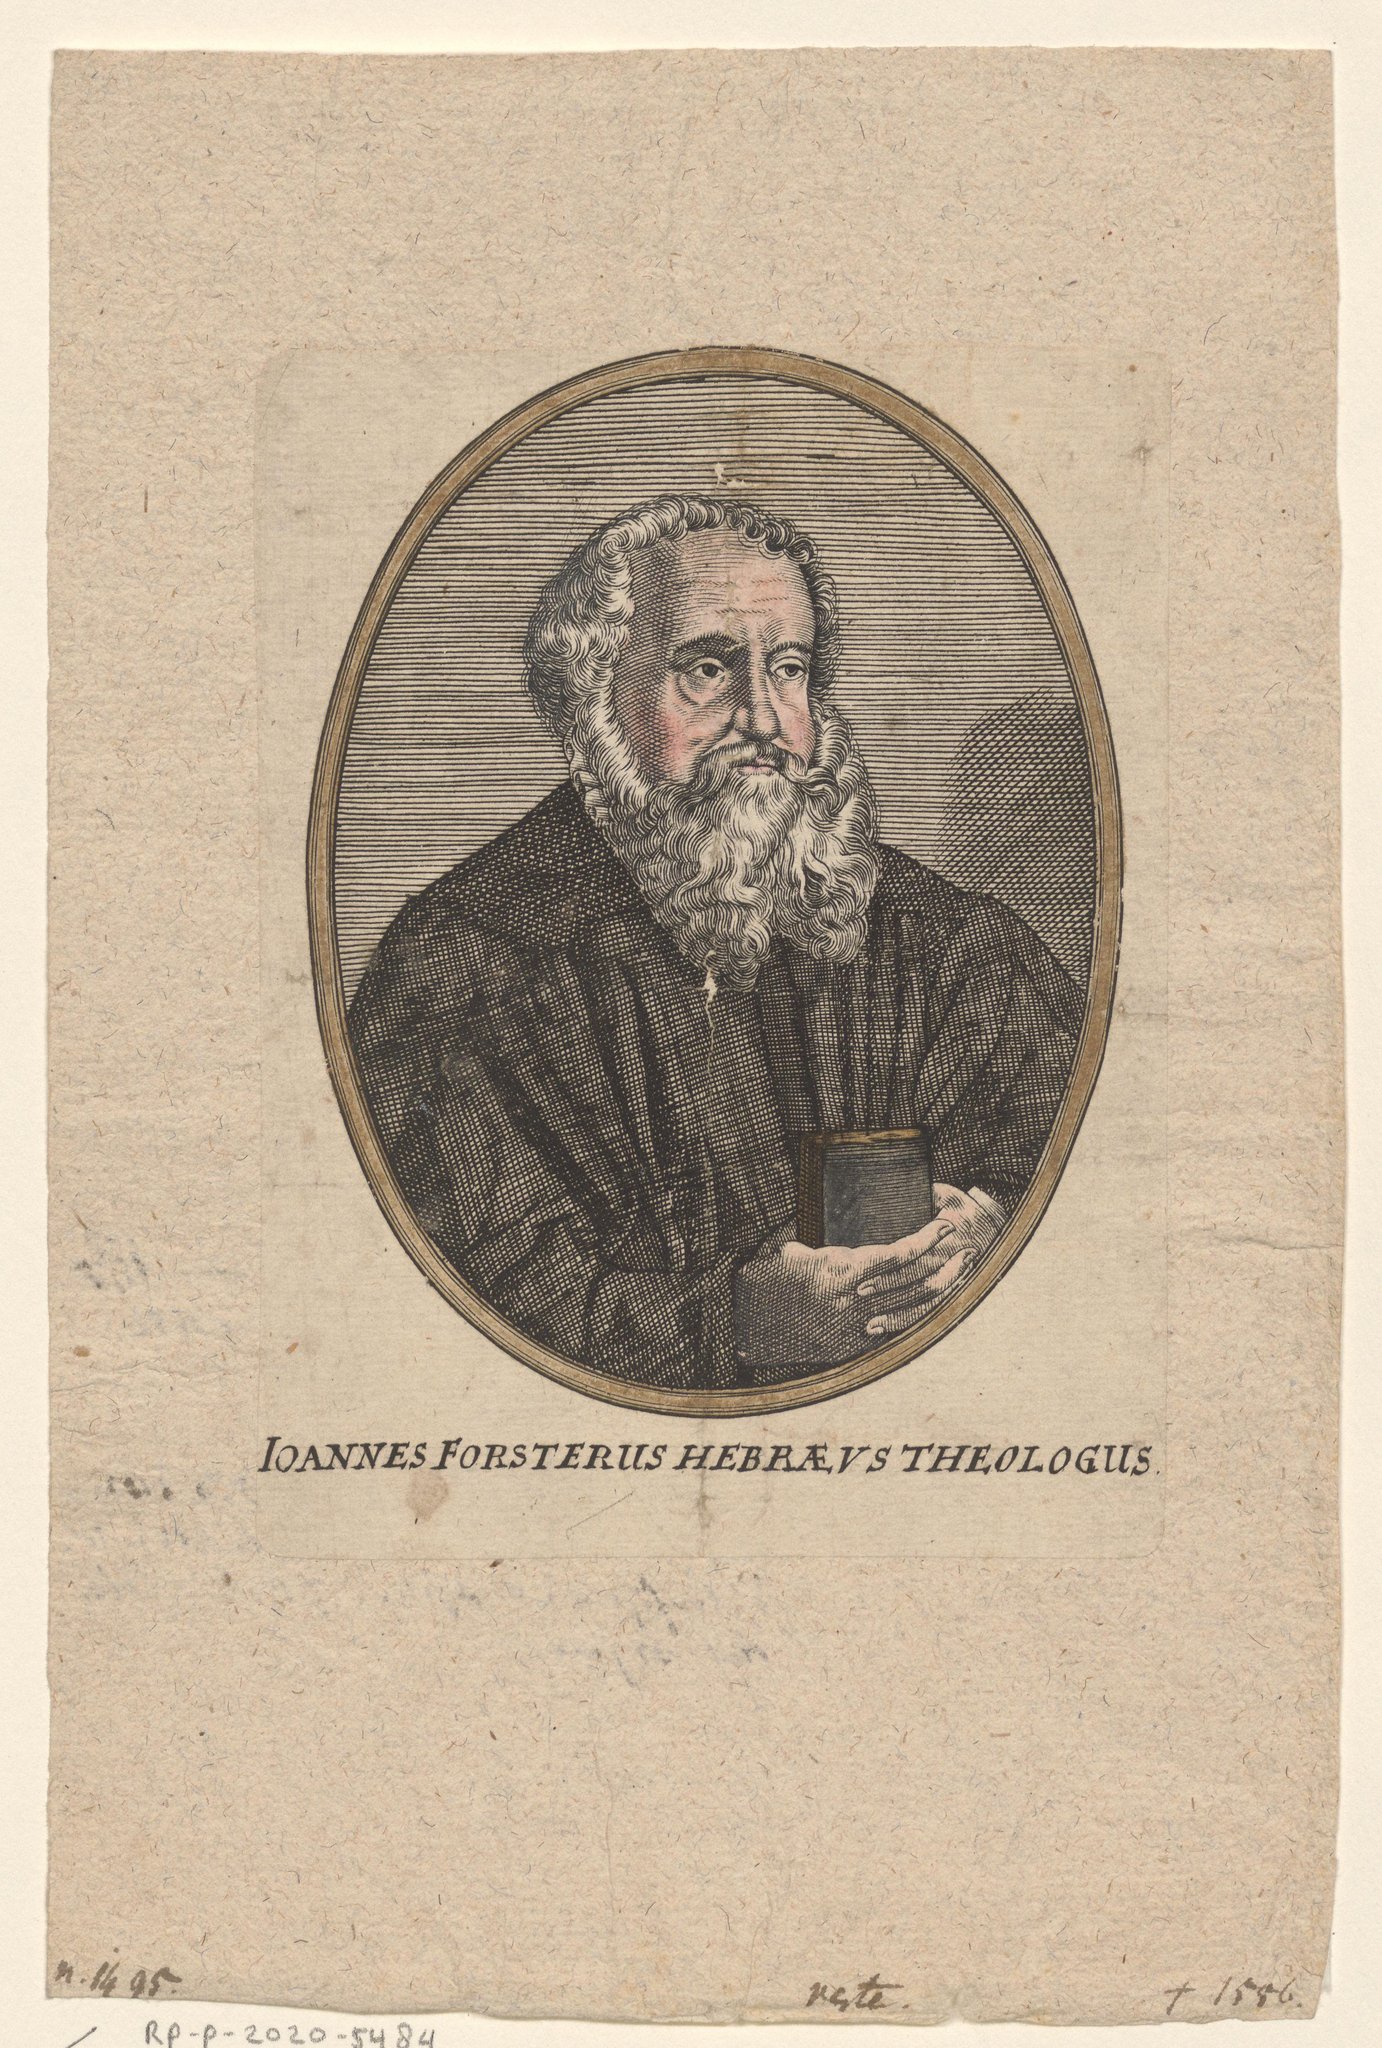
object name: print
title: Portret van Johann Forster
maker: Anonymous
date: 1600-1699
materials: paper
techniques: engraving, hand coloring, snipping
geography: germany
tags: augsburg, theologian, historical persons, book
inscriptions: inscription: ‘J.F. senior, Luther. Theolo., Philol., nat. Augsb. 10 Julii 1495. (...)’